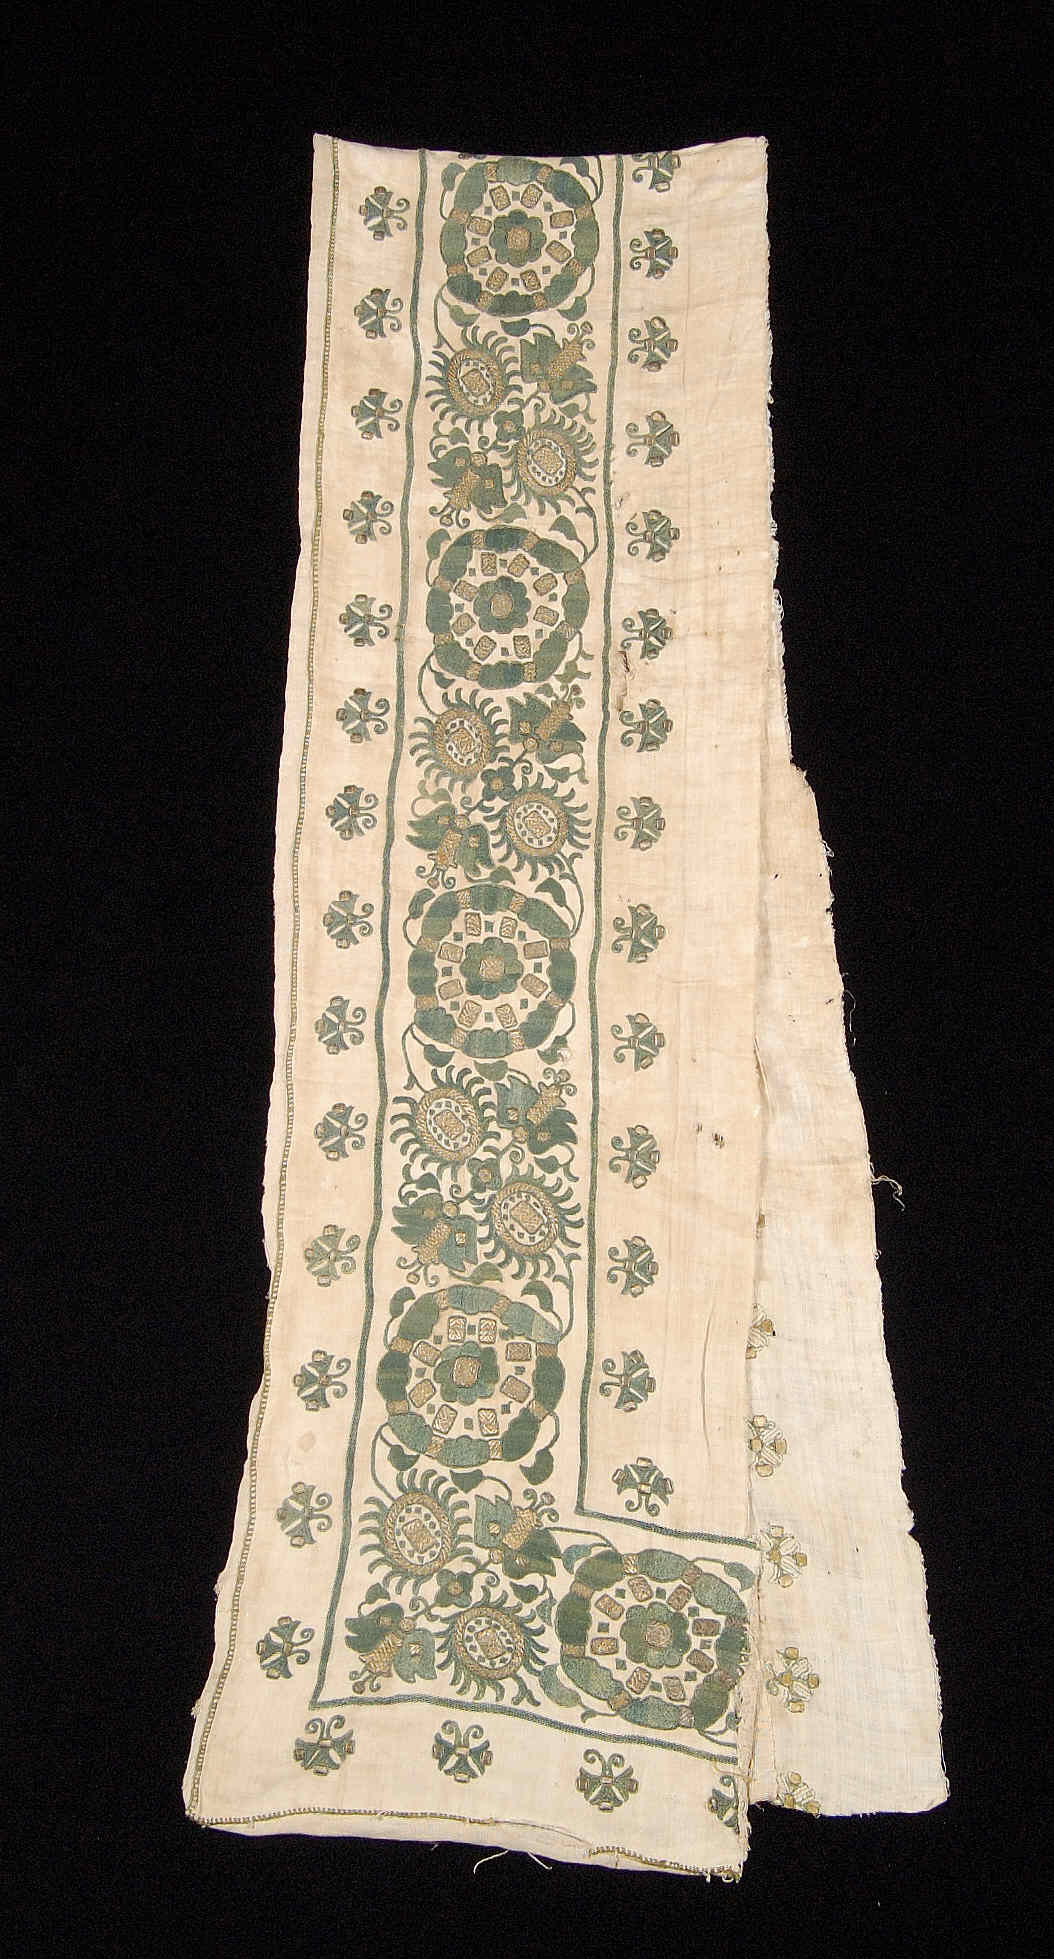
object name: textile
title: Fragment of a shirt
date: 1776-1800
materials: linen, silk